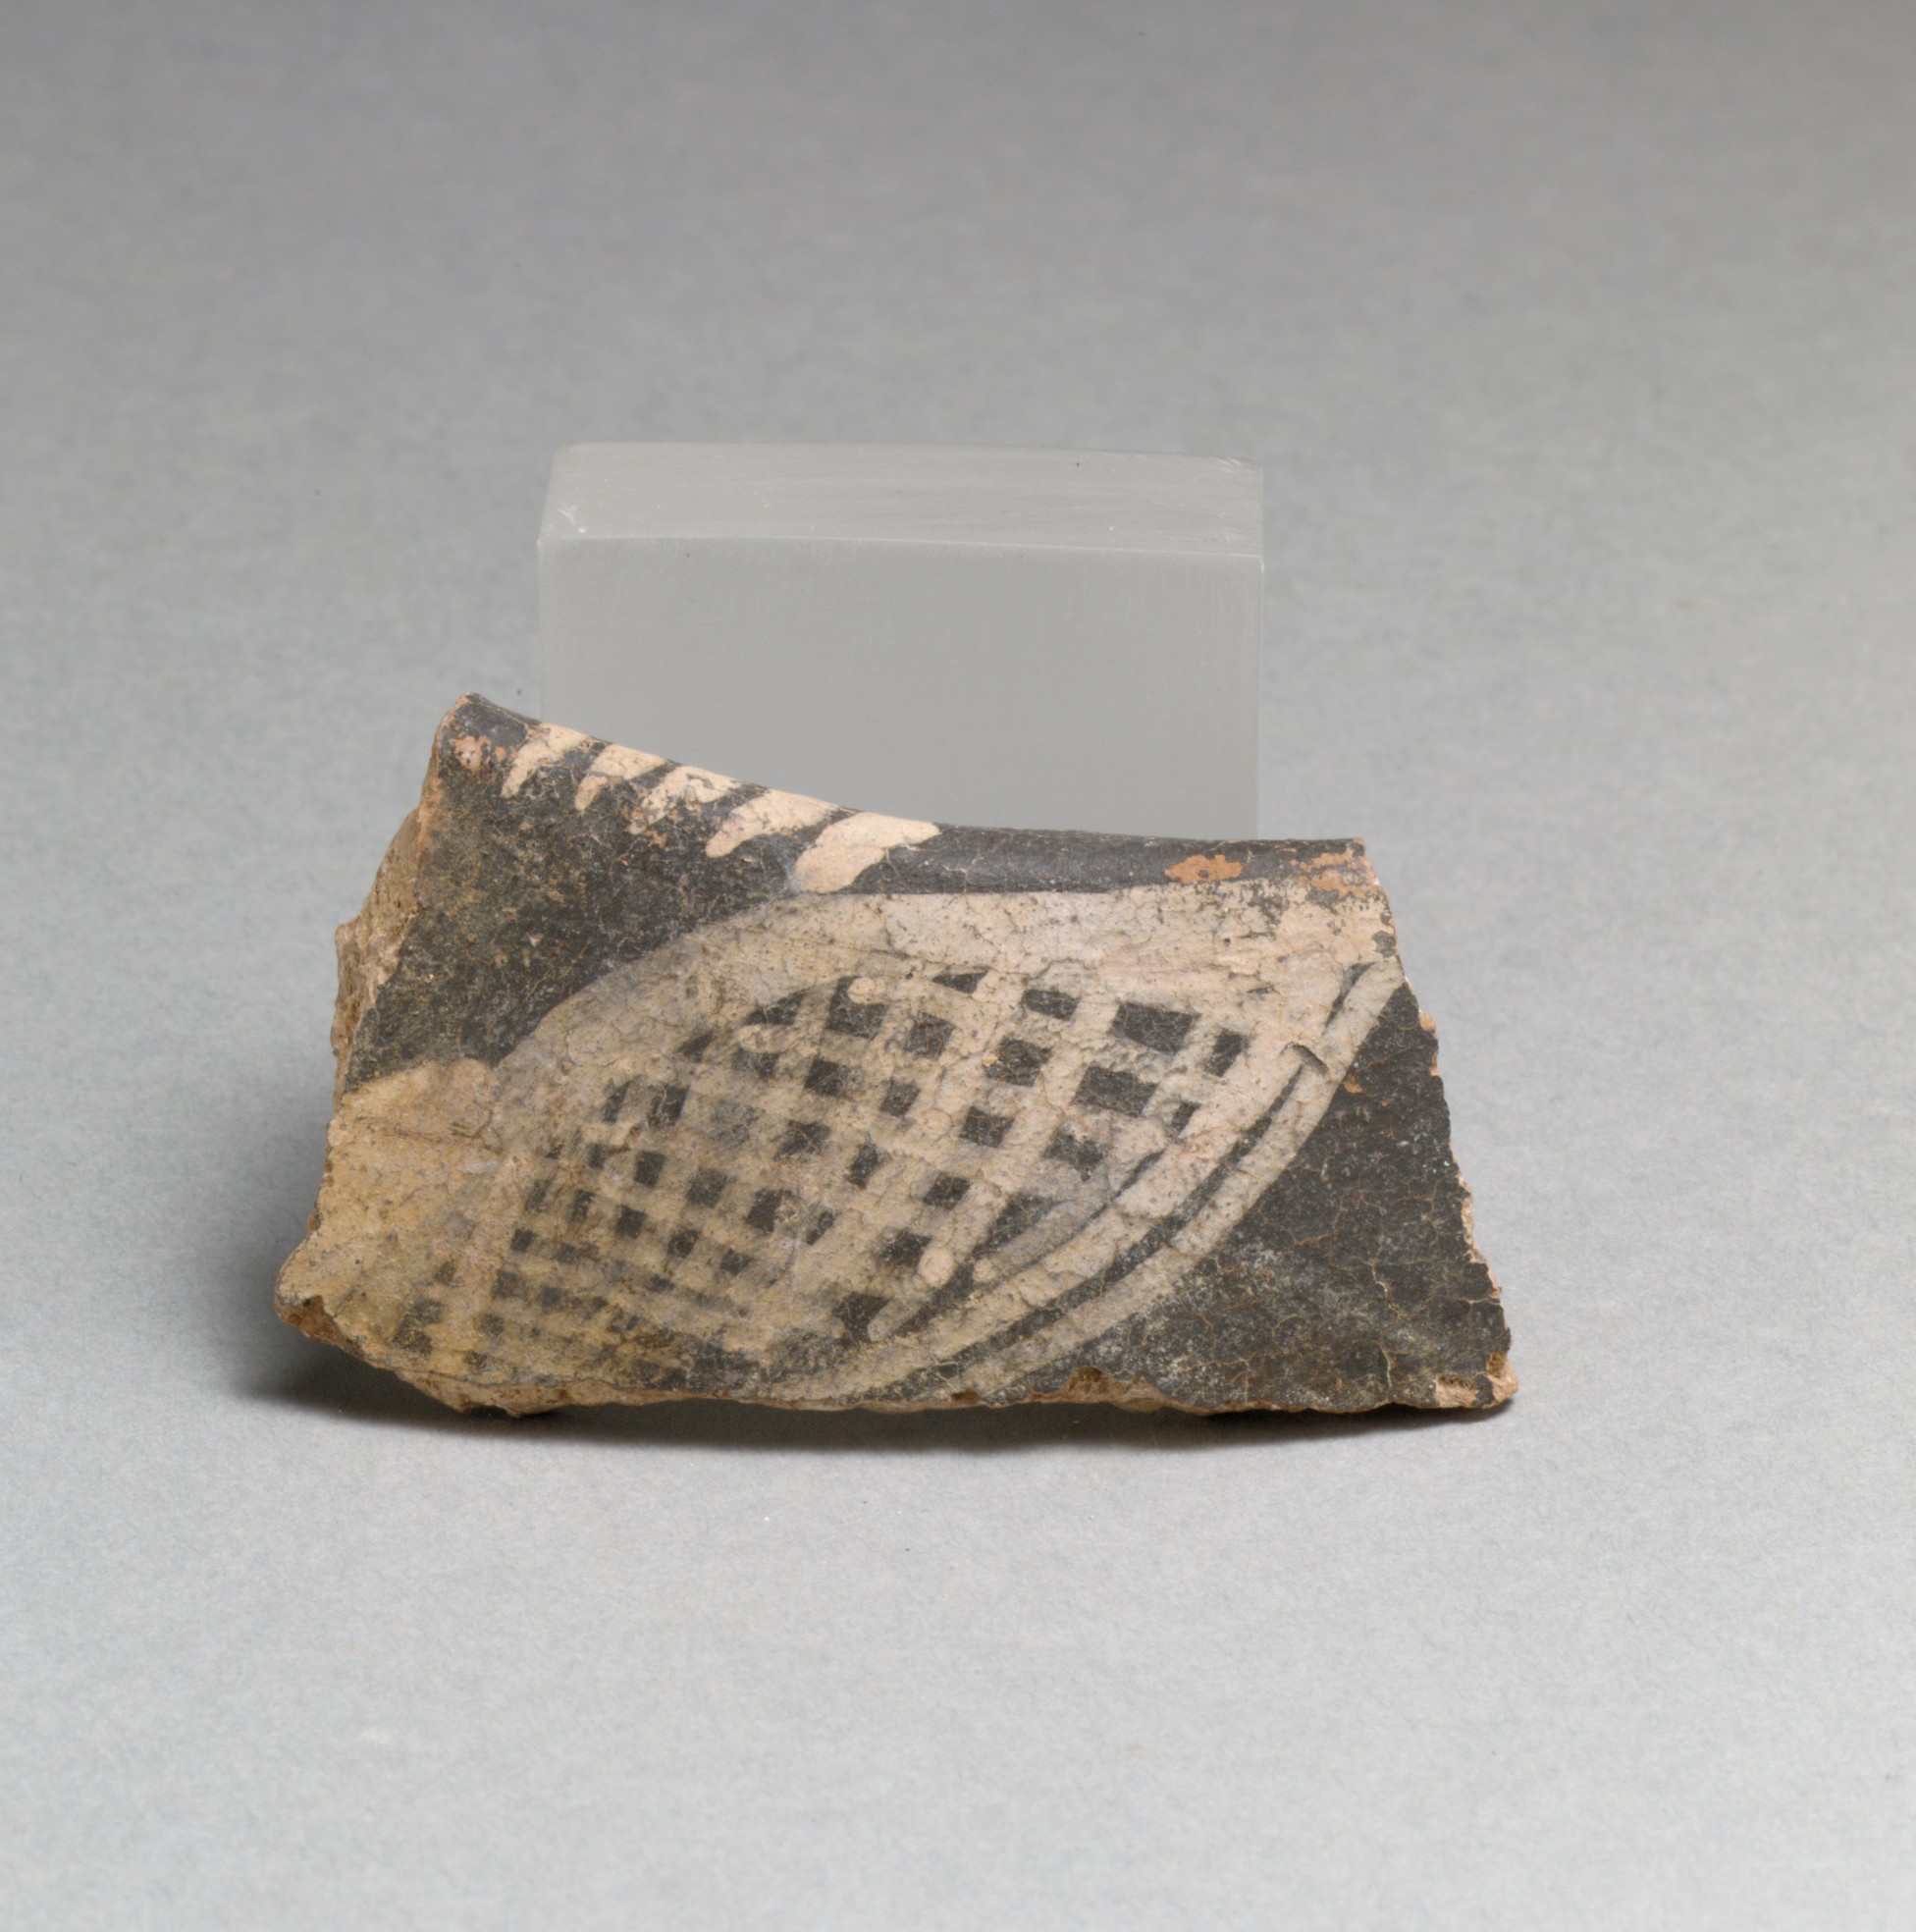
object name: vase fragment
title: Terracotta rim fragment with hatched form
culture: minoan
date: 2300-2100 BCE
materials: terracotta